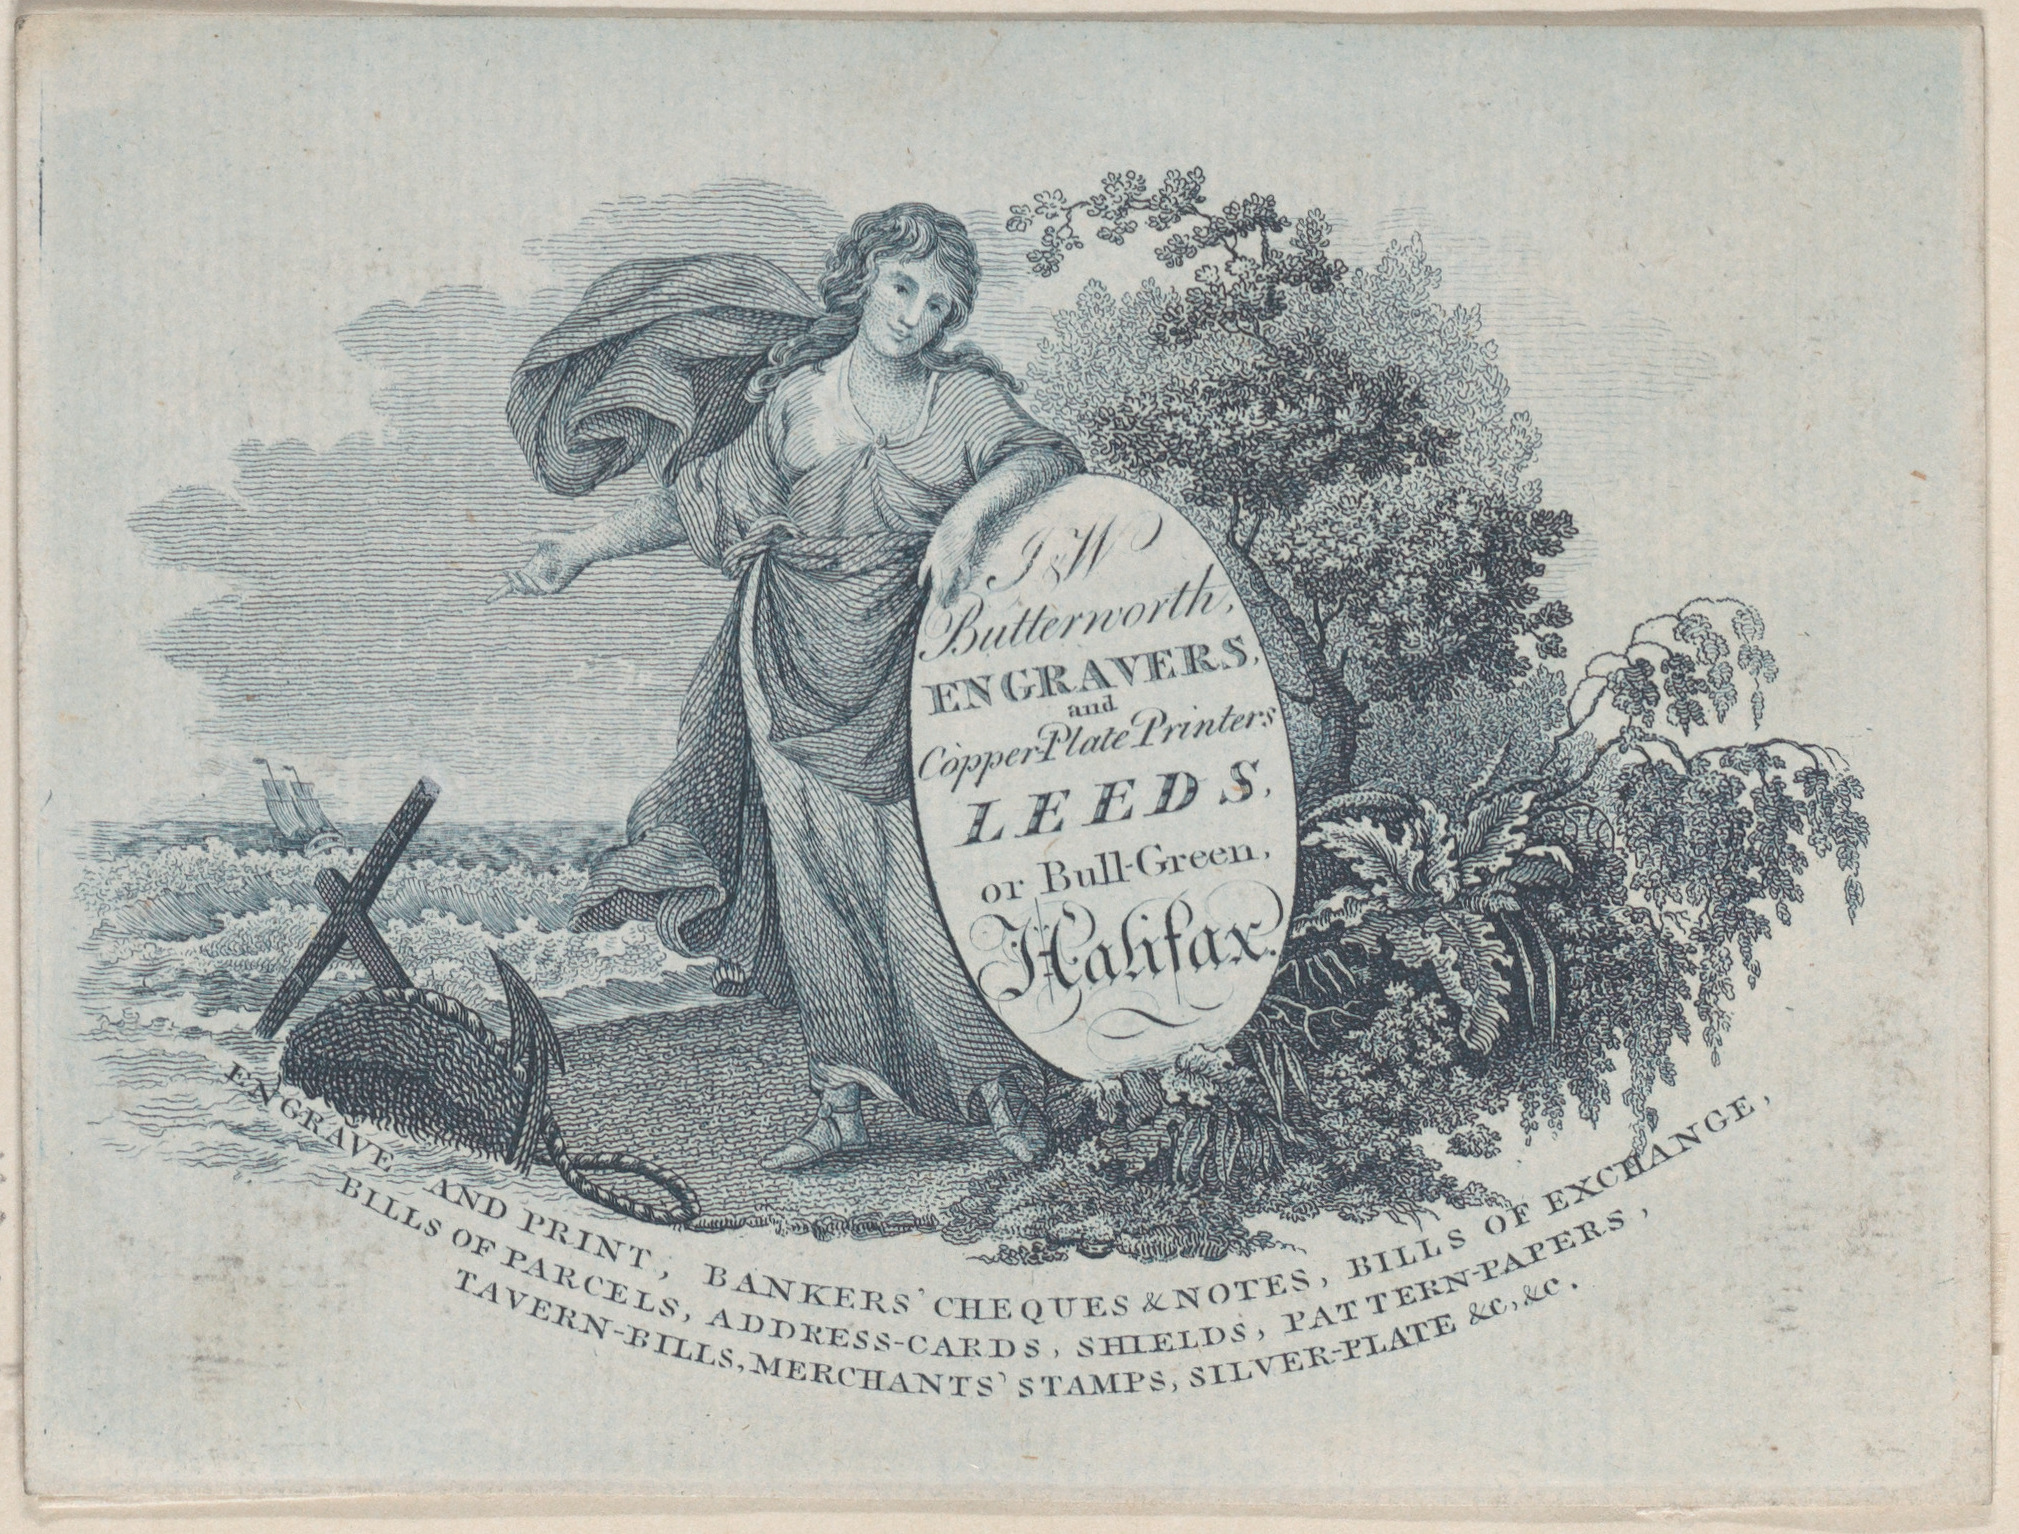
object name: print, trade card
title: Trade Card for J & W Butterworth, Engravers & Copper Plate Printers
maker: anonymous, british, 19th century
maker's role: artist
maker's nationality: british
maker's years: 1800-1900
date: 1801-1900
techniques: engraving